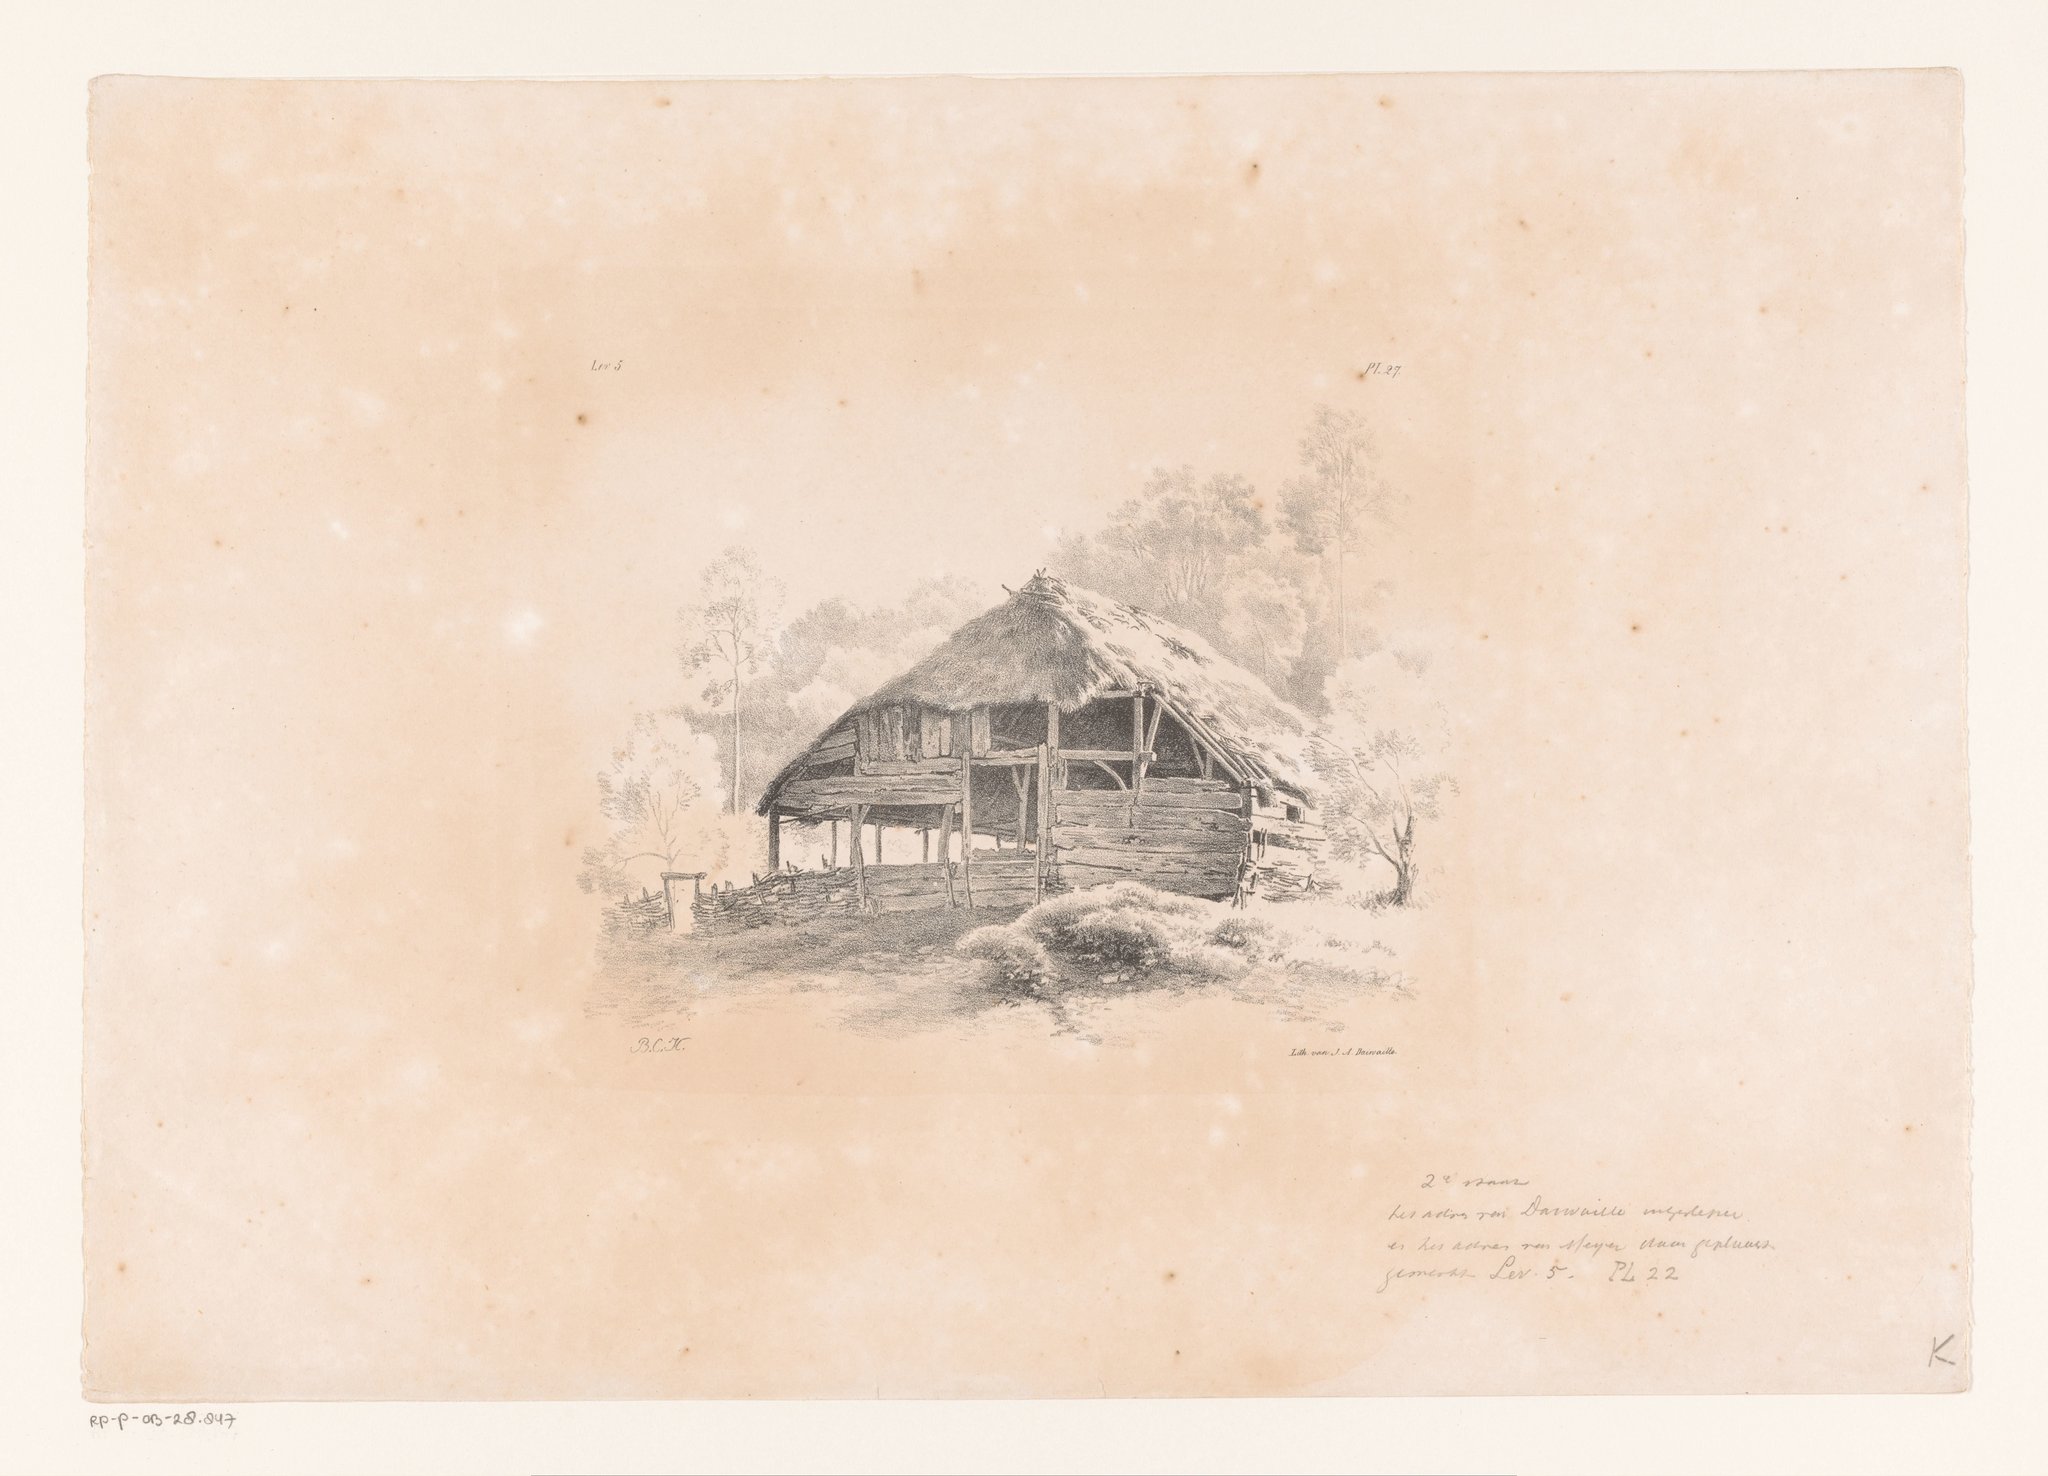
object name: print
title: Boerenschuur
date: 1829-1830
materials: paper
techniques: lithograph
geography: amsterdam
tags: barn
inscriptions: inscription: ‘2e staat / het adres van Daiwaille uitgeslepen / en het adres van Meyer daar geplaatst / genummerd Lev 5 PL. 22’, collector's mark: Lugt 2228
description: In 1829 en 1830 gaf Koekkoek, samen met Daiwaille, zes cahiers uit met ieder zes prenten getiteld Landschapstudiën. Deze werden gebruikt in het tekenonderwijs. Vijftien jaar later werd deze reeks, in een andere samenstelling nogmaals uitgegeven door Meyer en Comp in Amsterdam. Zie: De Bruyn Kops, 1963.